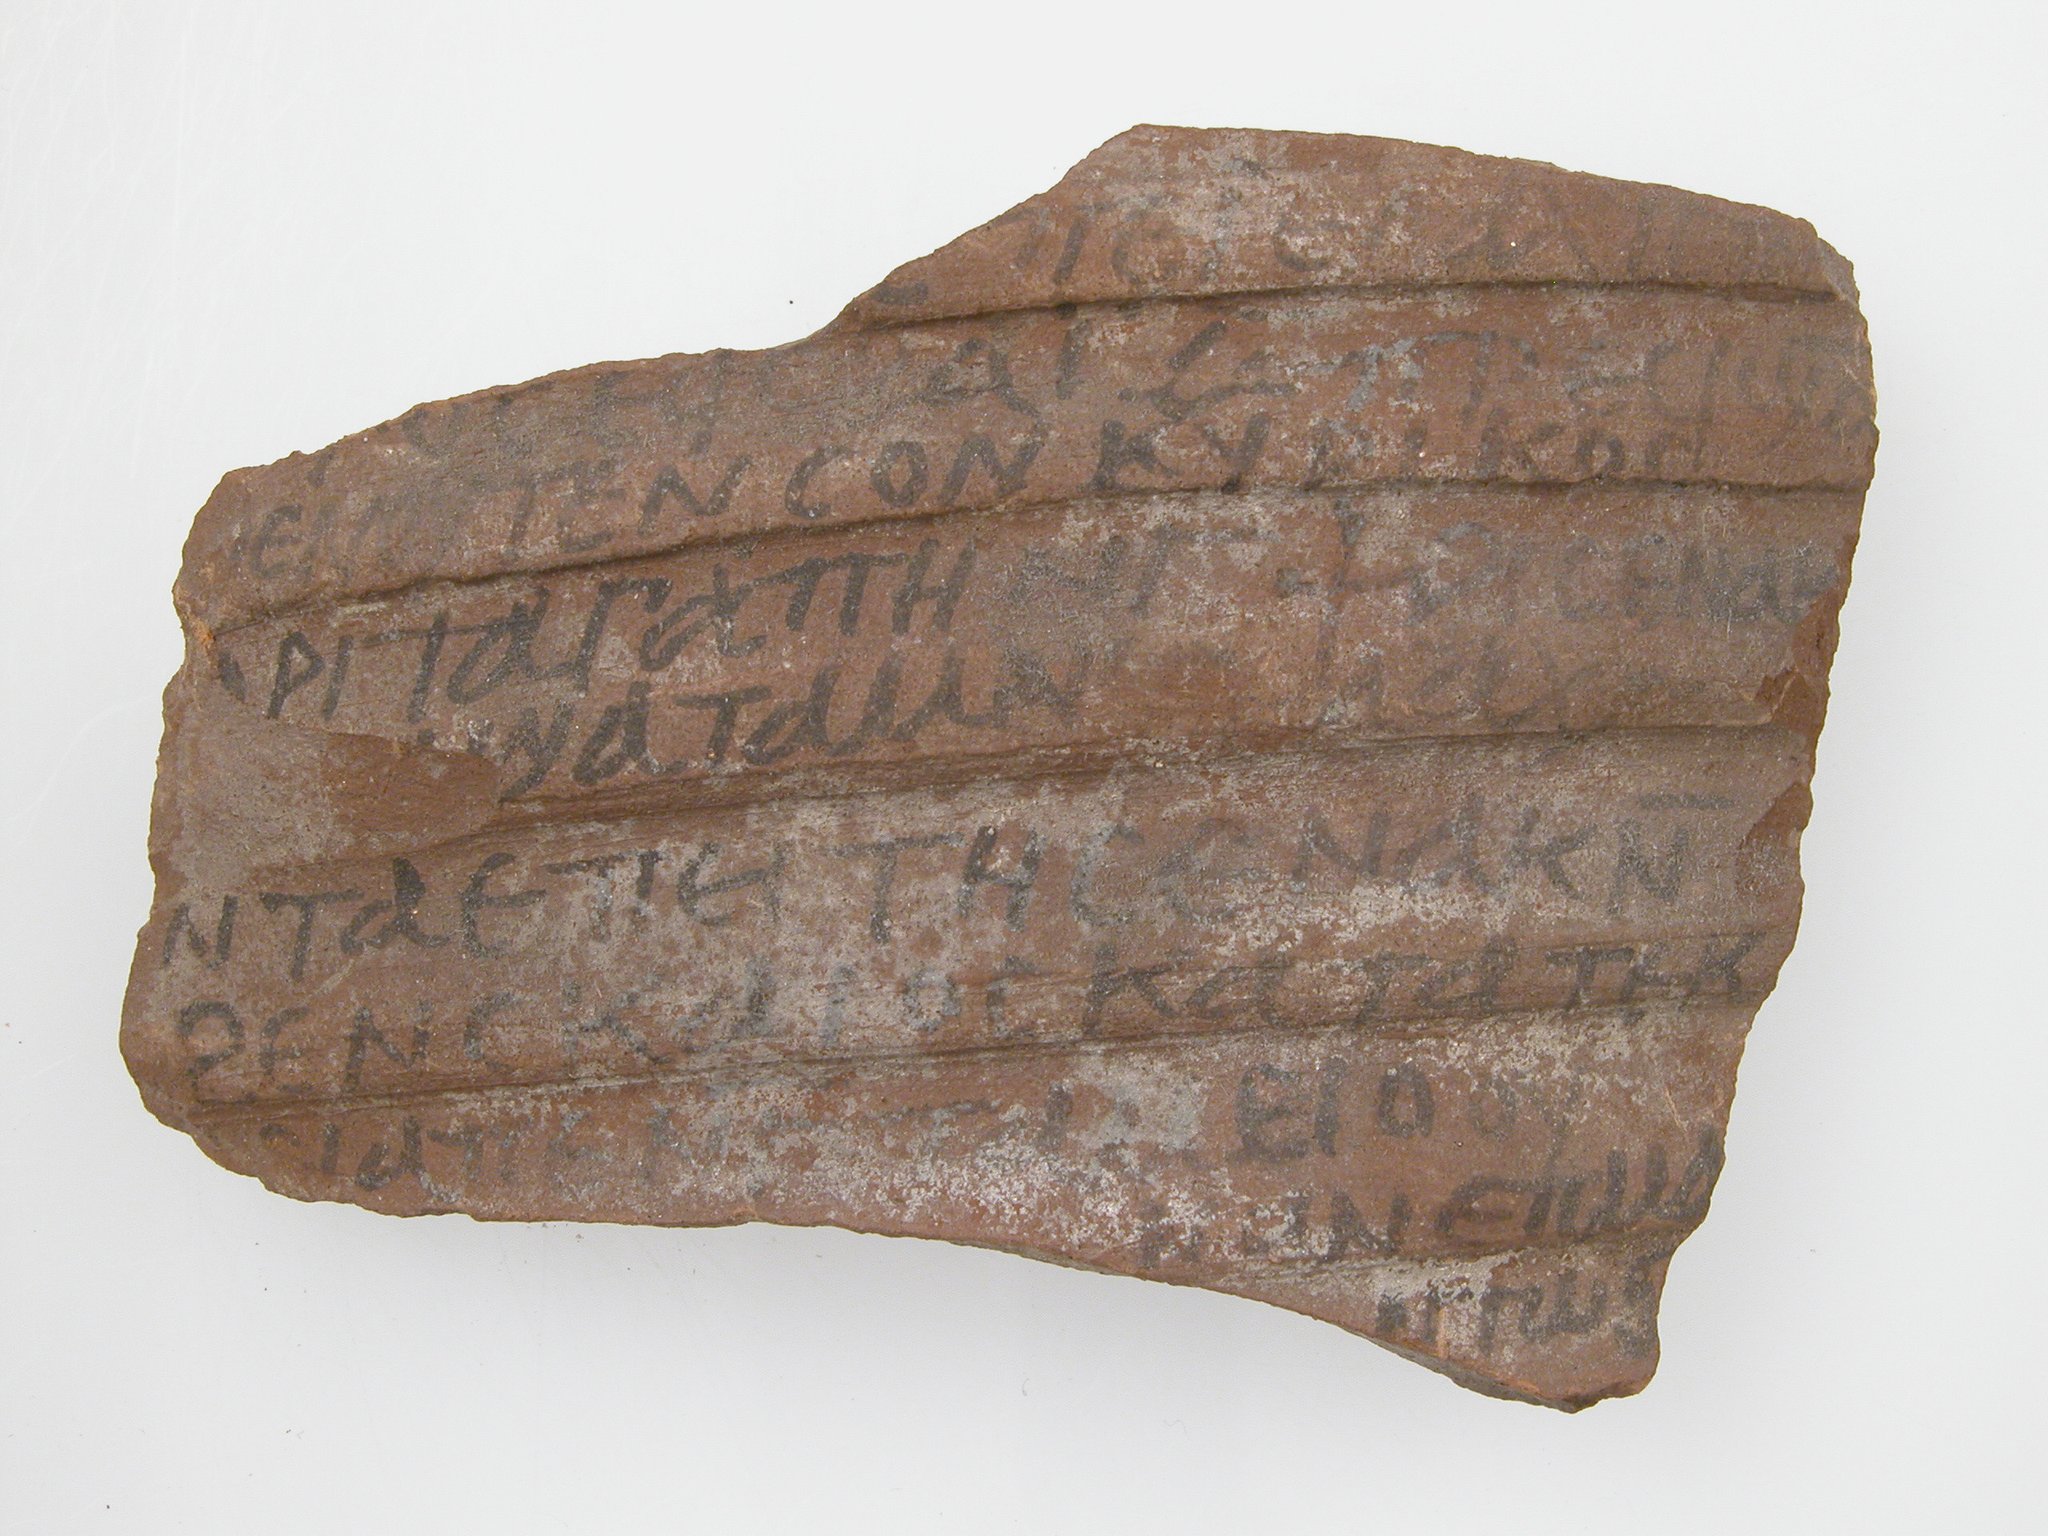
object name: ostrakon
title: Ostrakon with a Letter to Cyriacus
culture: coptic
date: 600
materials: ink, pottery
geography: egypt